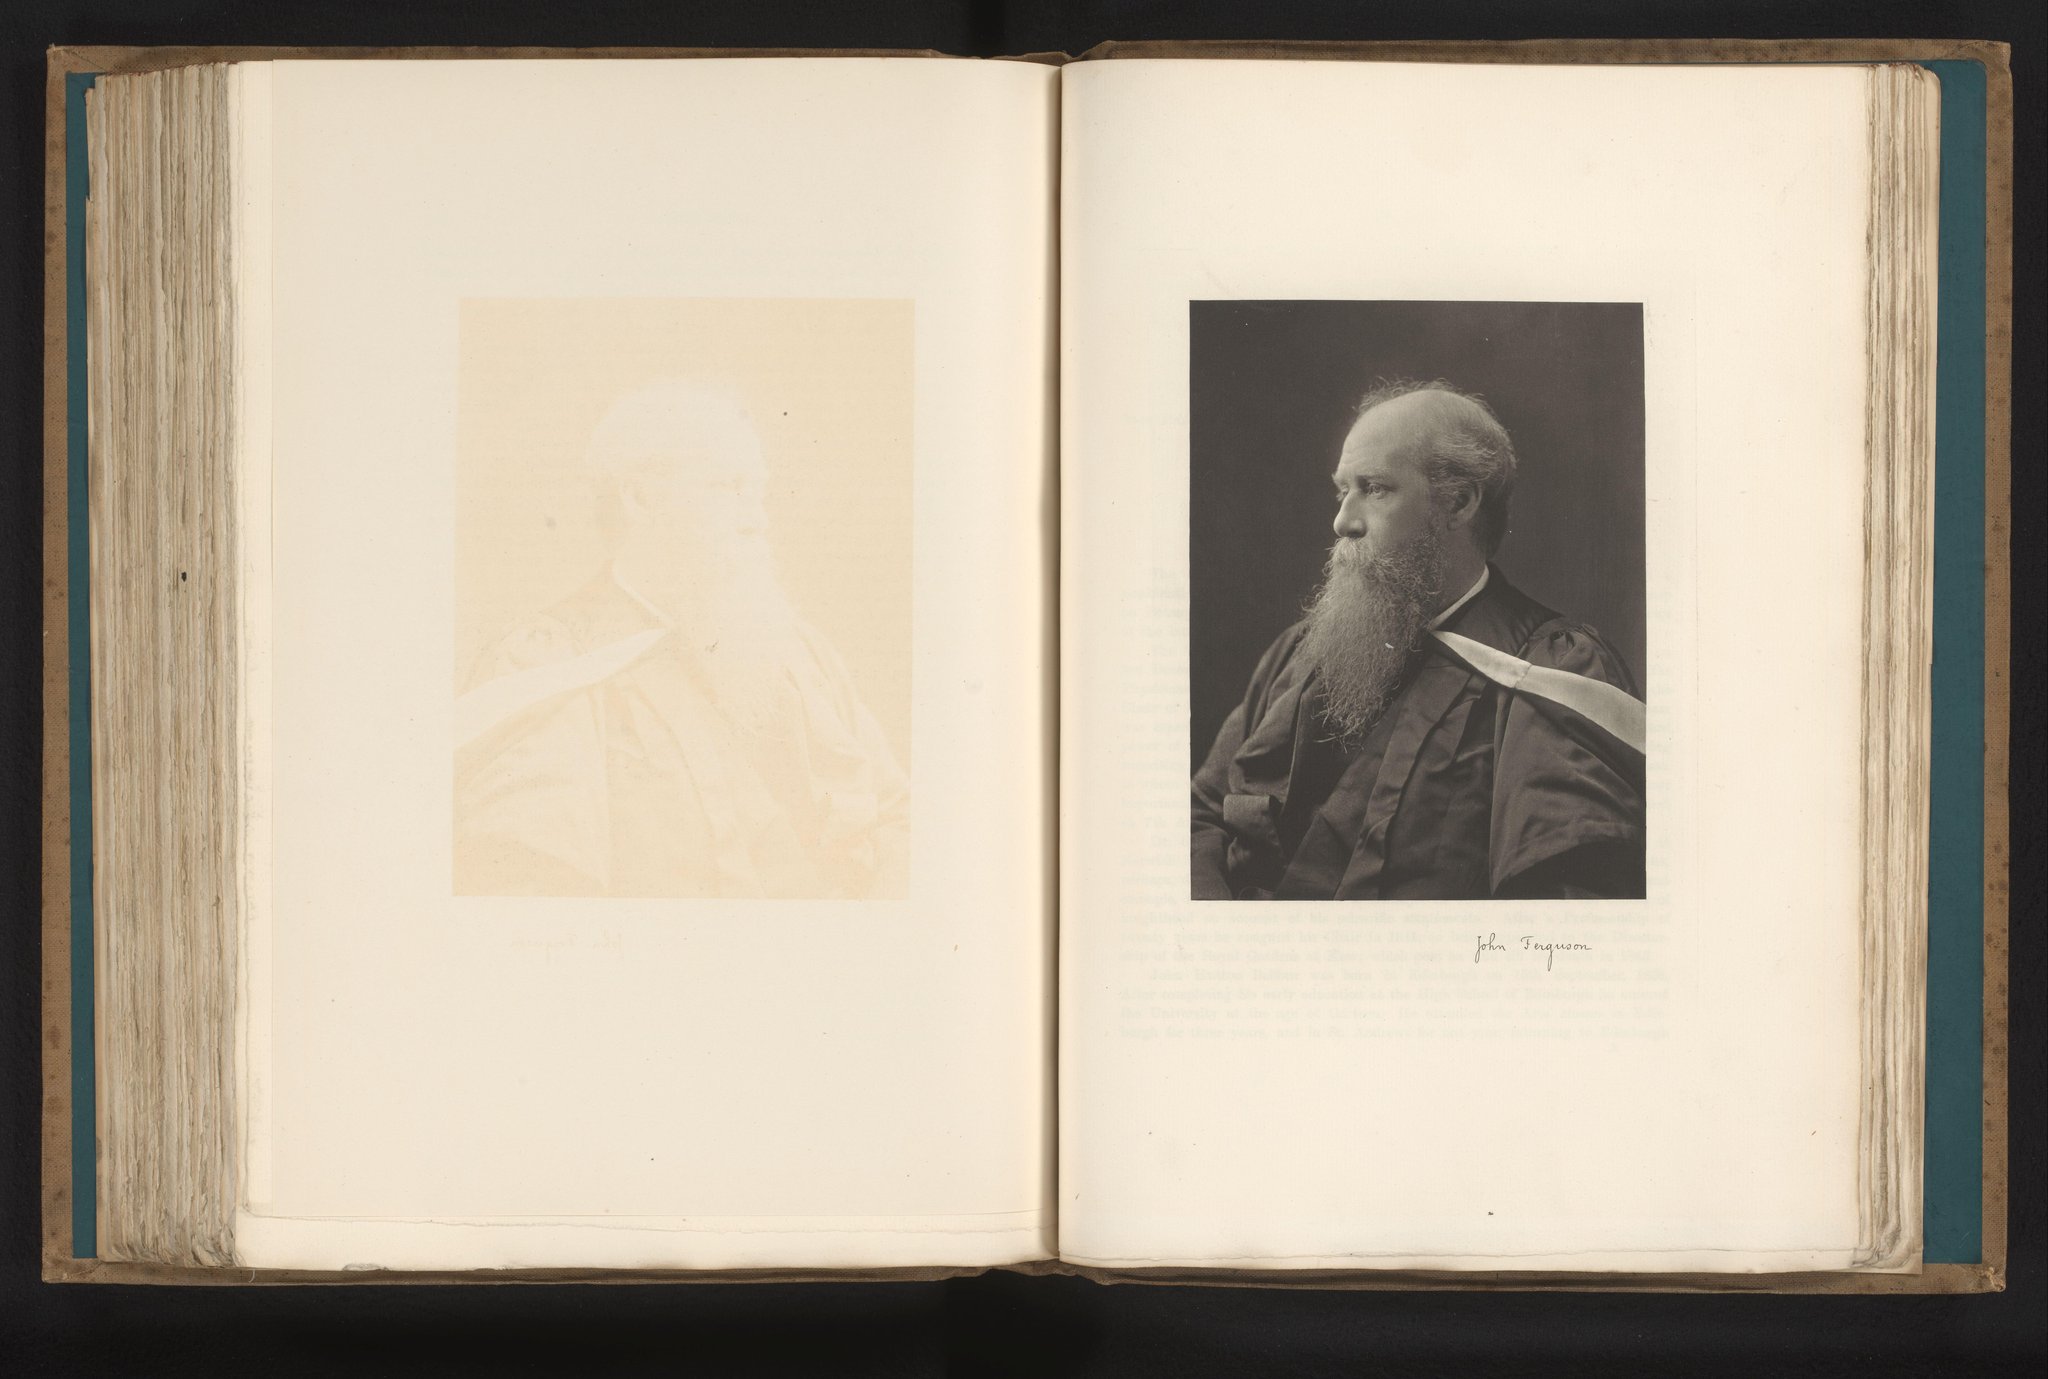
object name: page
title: John Ferguson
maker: Anonymous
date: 1886-1891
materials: paper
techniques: photoaquatint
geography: glasgow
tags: glasgow, historical persons, professor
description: Prent op tweede ongenummerde pagina na pagina 121.